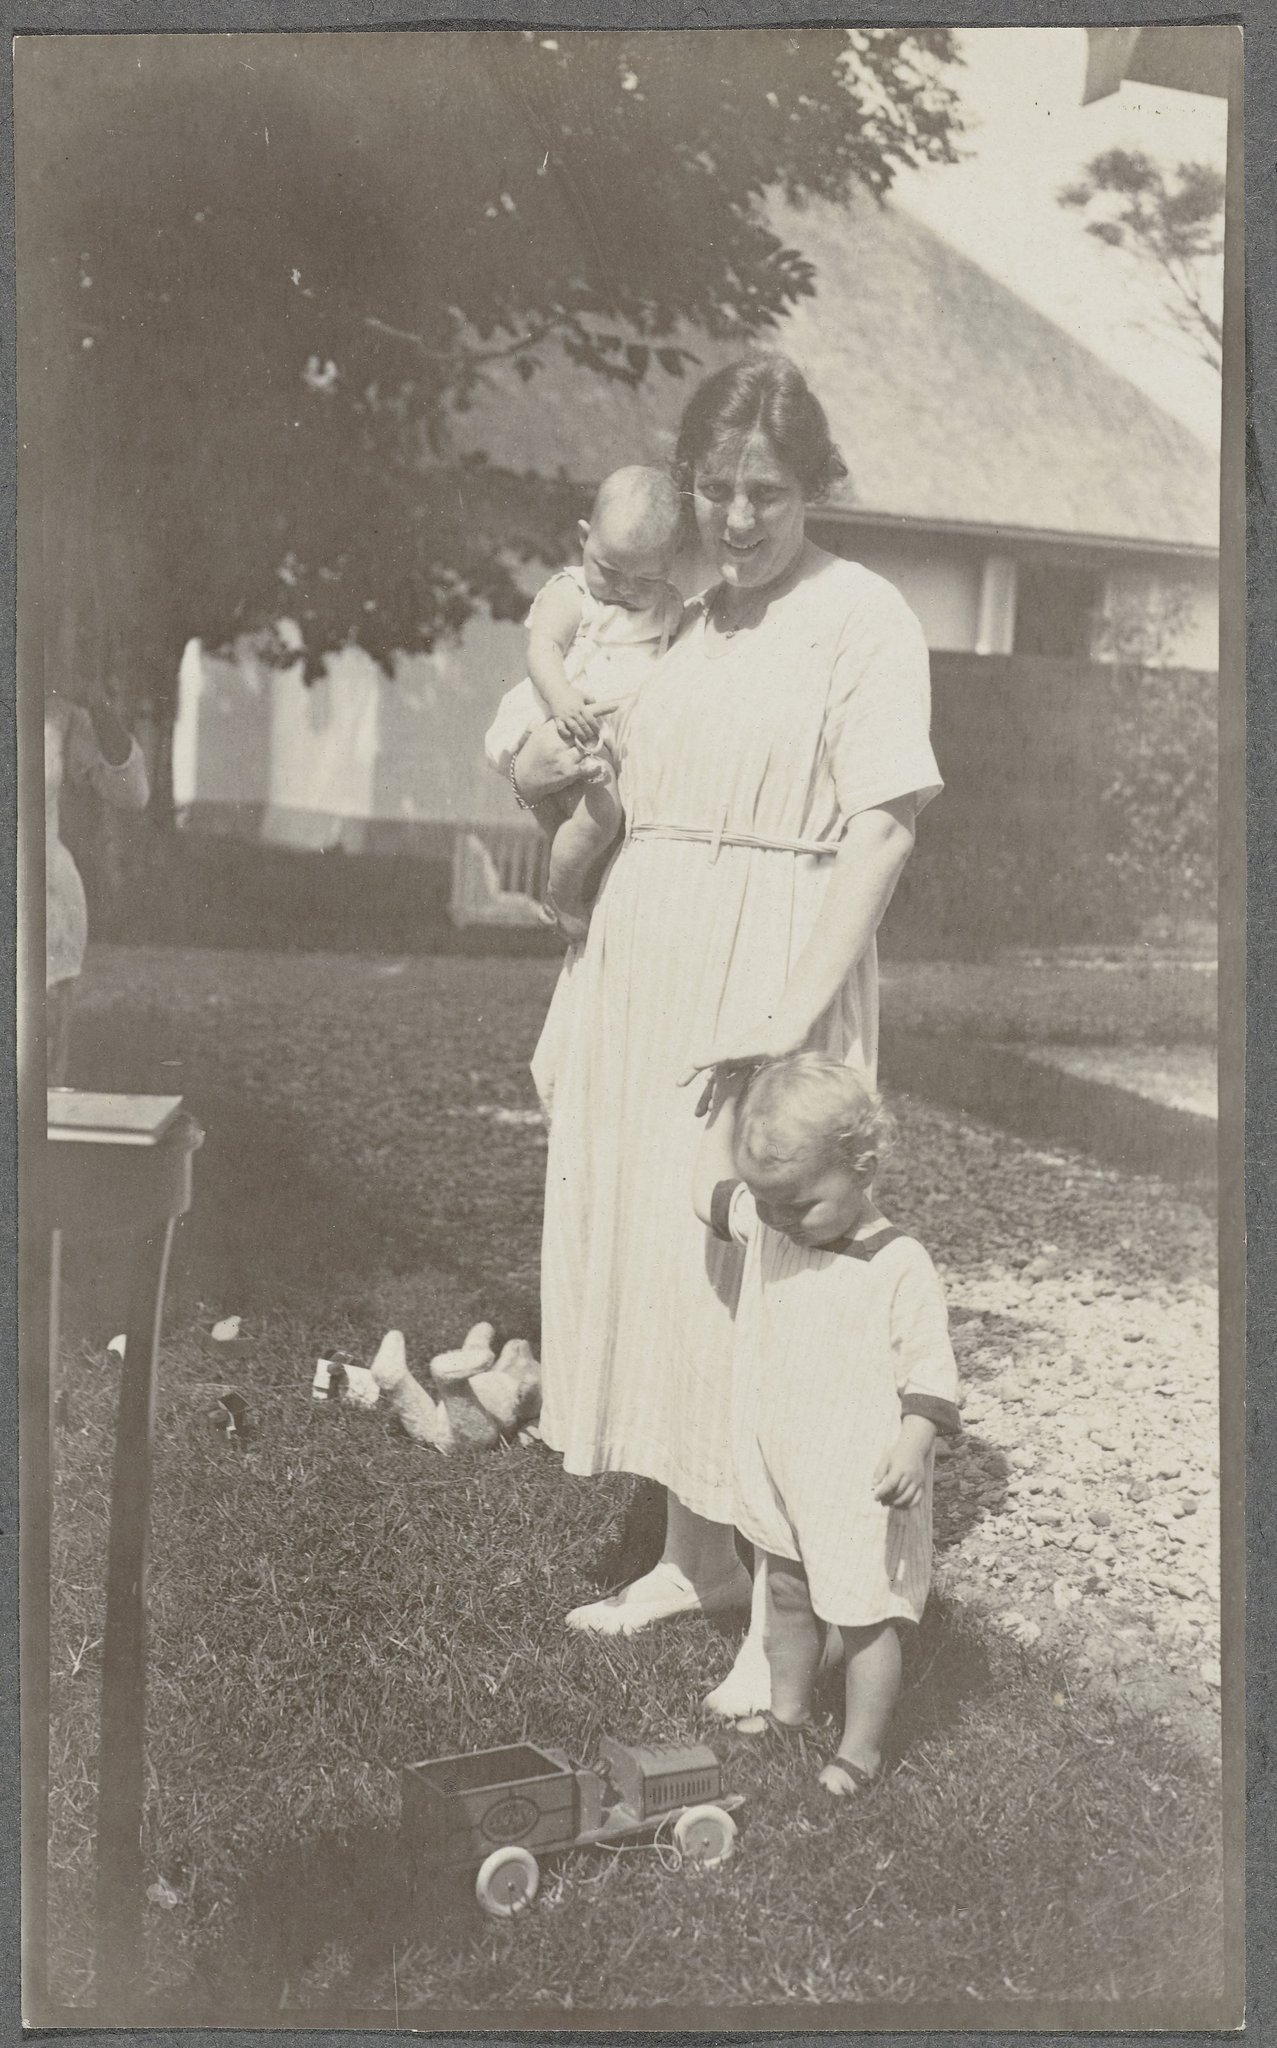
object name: photograph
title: Tine Kleiterp-Vermeulen en haar kinderen Klaas en Tiny op een grasveld in Madje op Celebes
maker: klaas kleiterp (i)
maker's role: arts, officier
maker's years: 1892-1943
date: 1922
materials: paper, photographic support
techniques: daylight paper print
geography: madjene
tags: garden, mother and baby or young child, (playing with) toys, dutch east indies, the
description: Onderdeel van Fotoalbum van de familie Kleiterp-Vermeulen met opnames van de kinderen Klaas en Tiny in Nederlands-Indië.